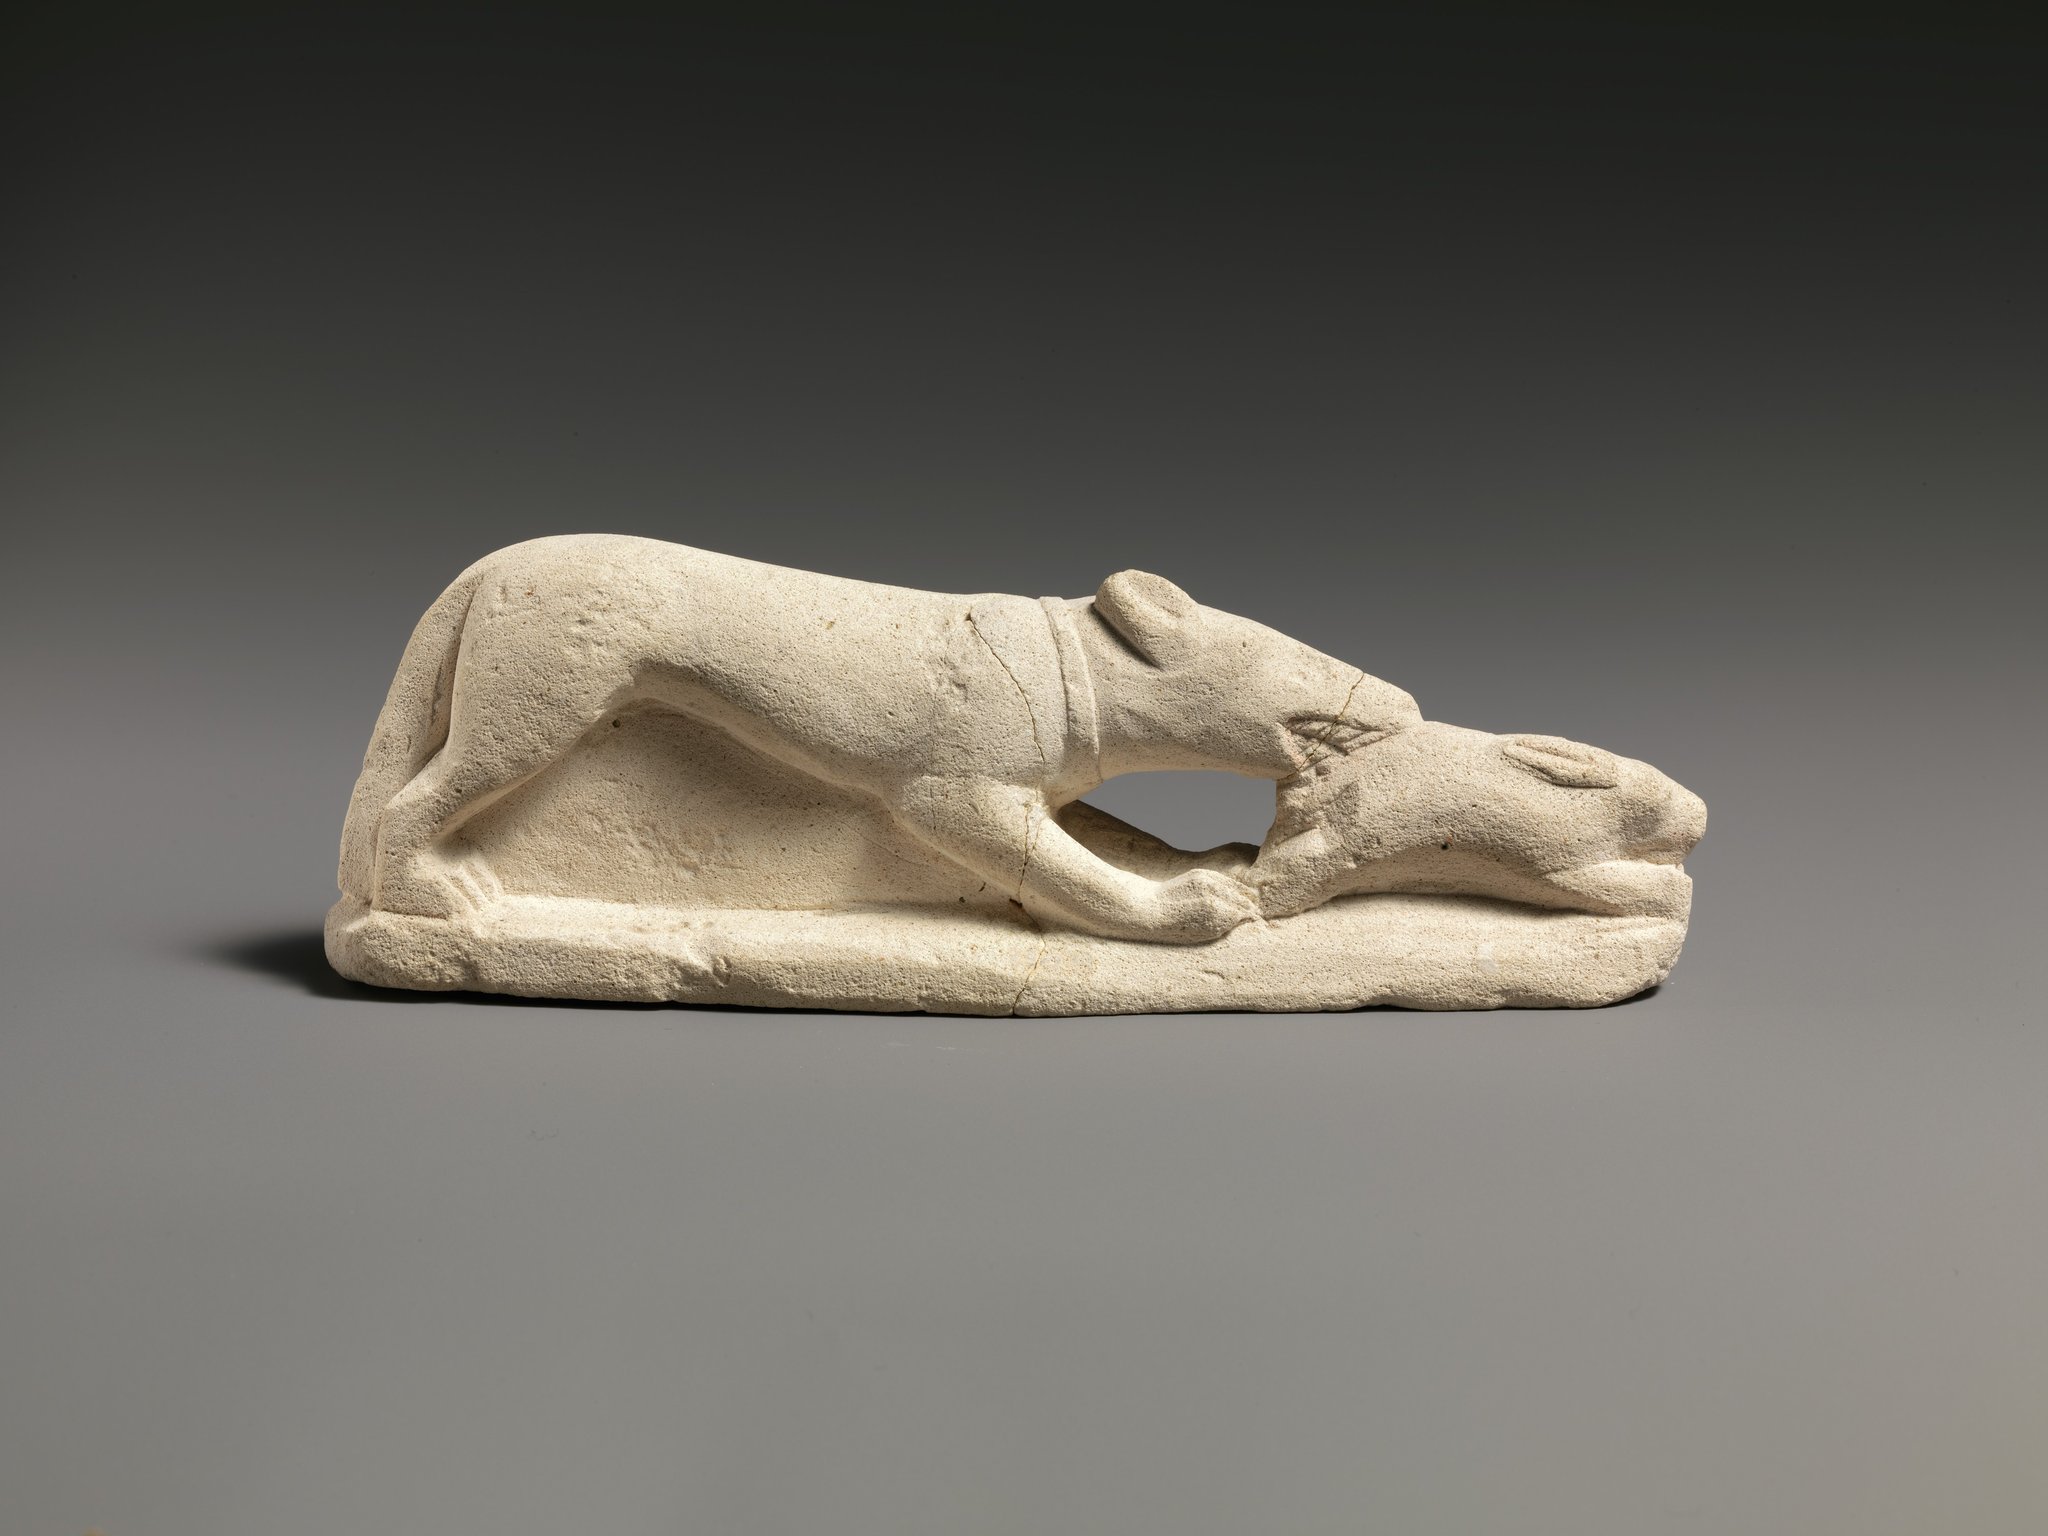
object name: statuette of a dog seizing a hare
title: Limestone statuette of a coursing hound seizing a hare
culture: cypriot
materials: limestone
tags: hunting,dogs,rabbits